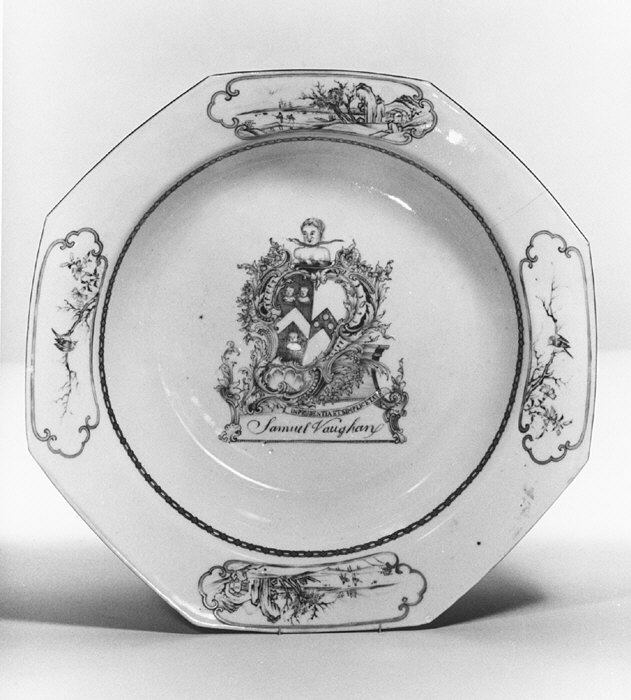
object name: soup plate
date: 1750-1755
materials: hard paste porcelain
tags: heads,coat of arms